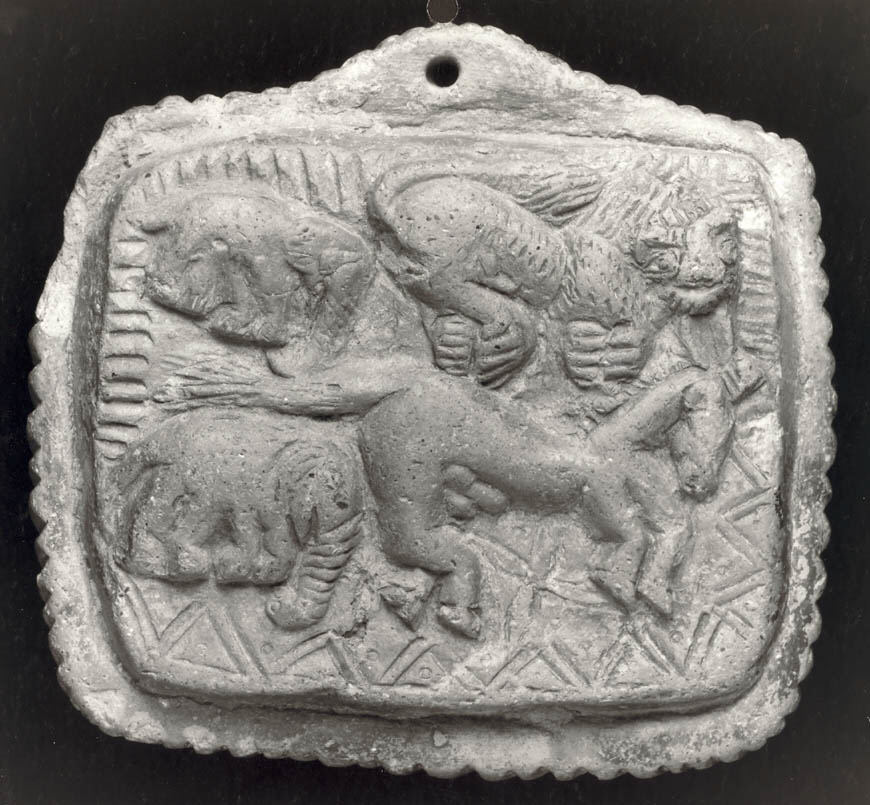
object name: rattle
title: Rattle with Animals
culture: indian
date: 1-100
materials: terracotta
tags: shunga,elephants,horses,lions